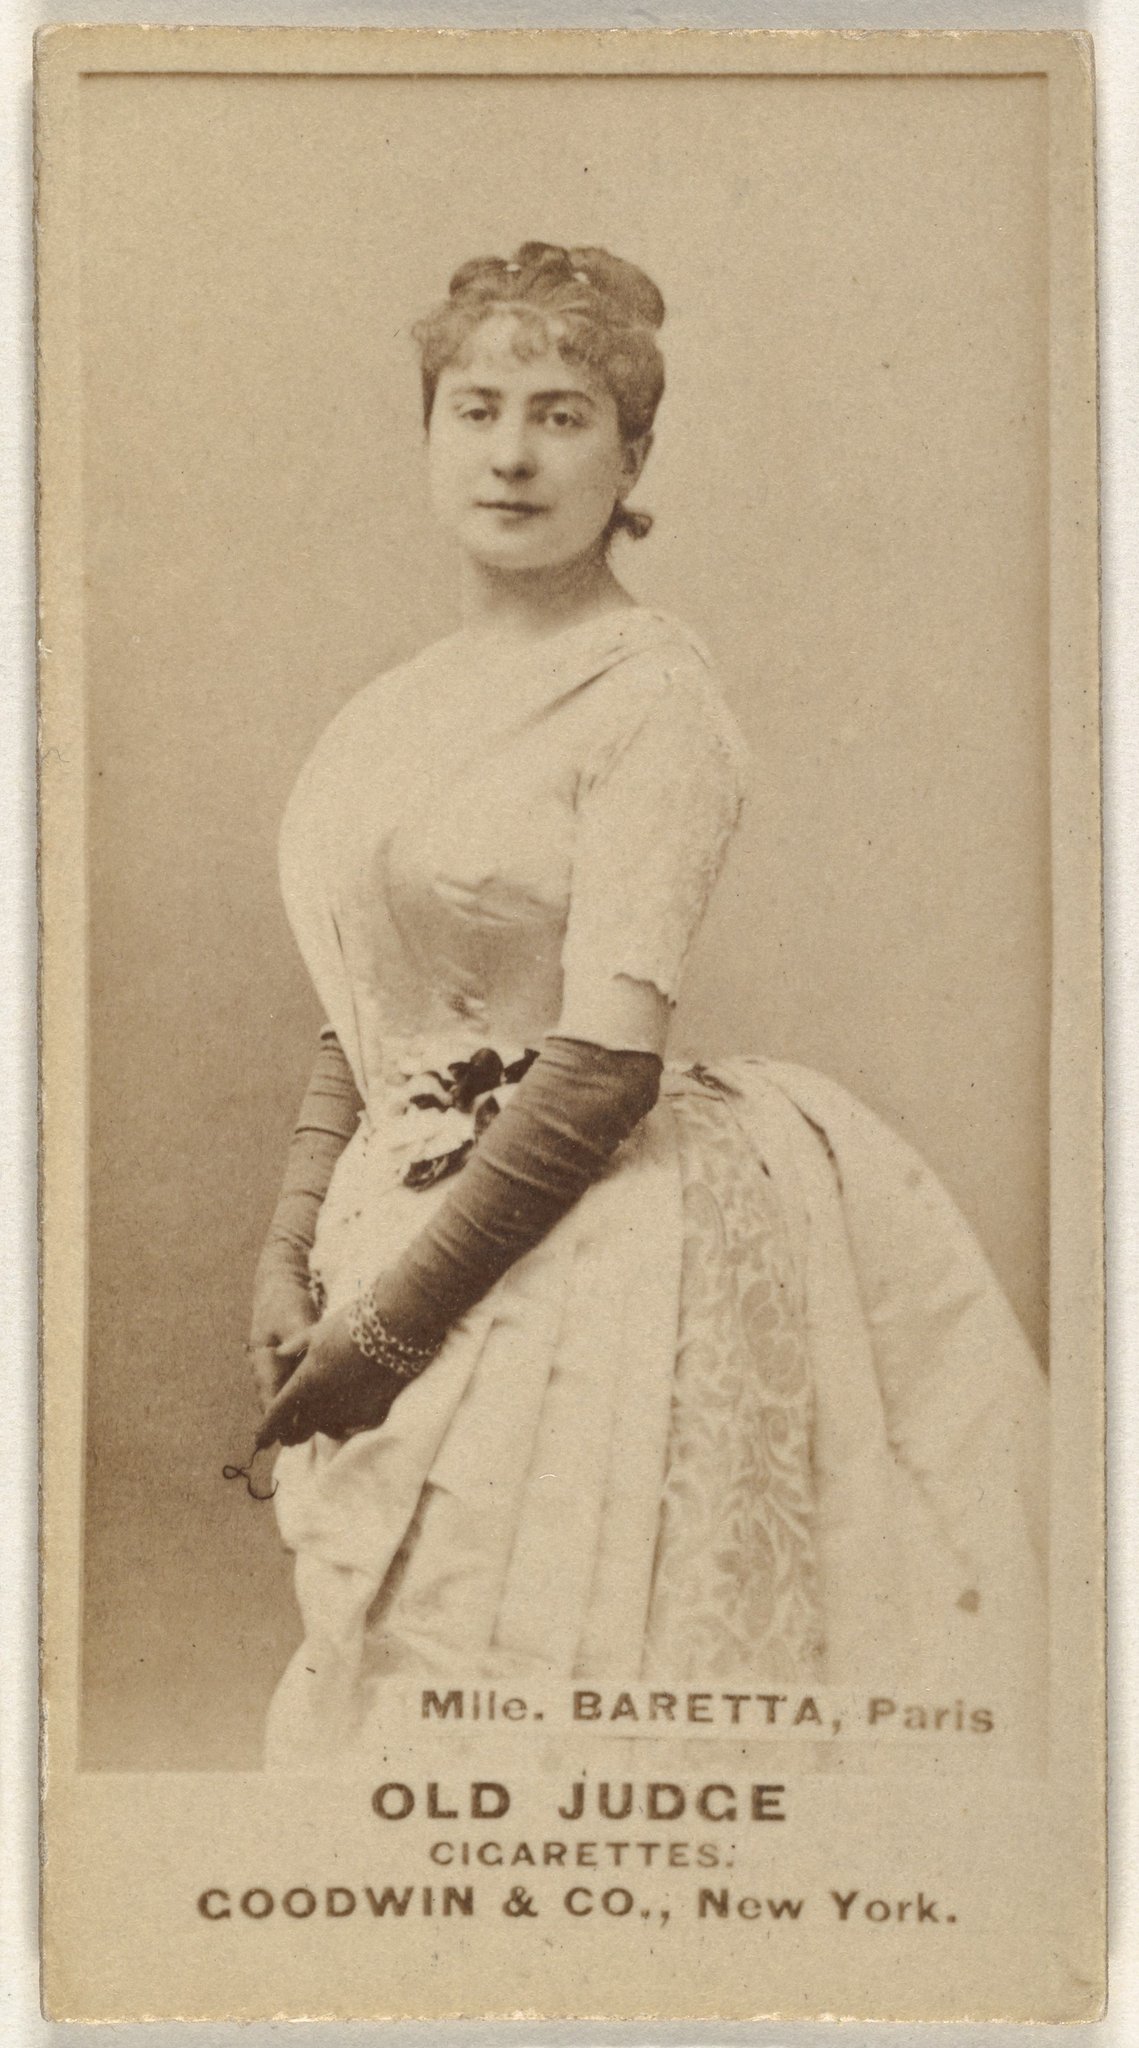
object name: photograph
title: Mlle. Baretta, Paris, from the Actors and Actresses series (N171) for Old Judge Cigarettes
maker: goodwin & company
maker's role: publisher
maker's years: 1850-1950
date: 1886-1890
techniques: albumen silver print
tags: portraits,women,actresses